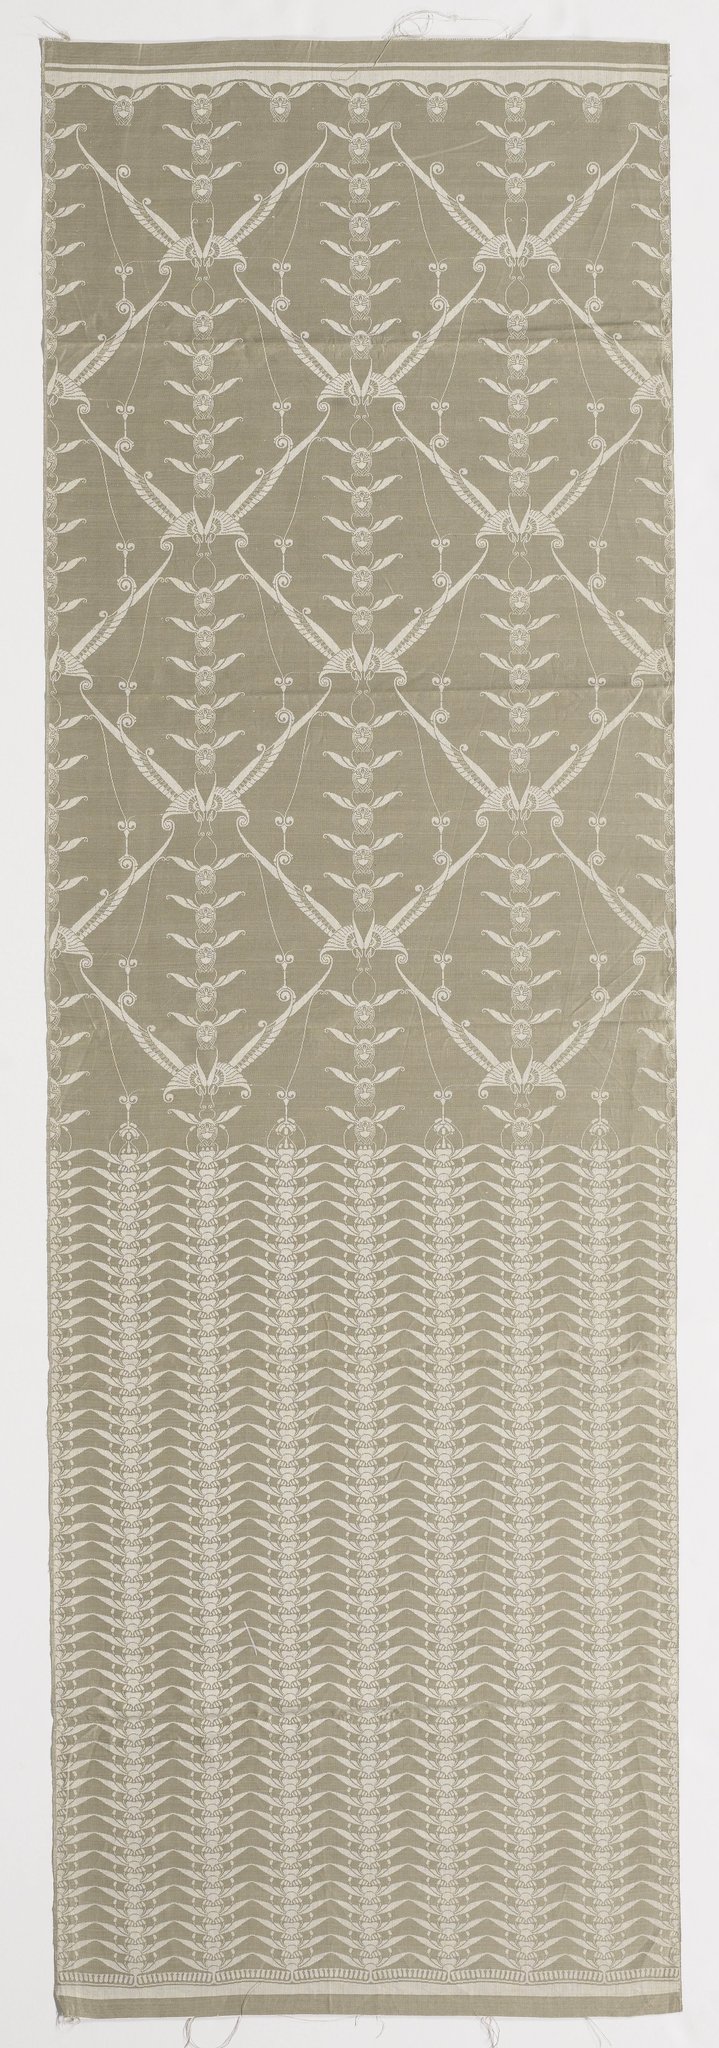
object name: upholstered wall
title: Fabric covering with ‘Lotos’ and ‘Wild Flight’ patterns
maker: chris lebeau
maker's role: draughtsman, print maker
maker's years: 1878-1945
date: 1911-1915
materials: linen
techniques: damask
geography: eindhoven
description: People of means hung the walls of their sitting rooms with decorative panels of this kind of fabric. Amsterdam designer Chris Lebeau created patterns based on nature. He dispersed leaves, calyxes and winged insects, for example, in a strict rhythmic order over the surface of the cloth.